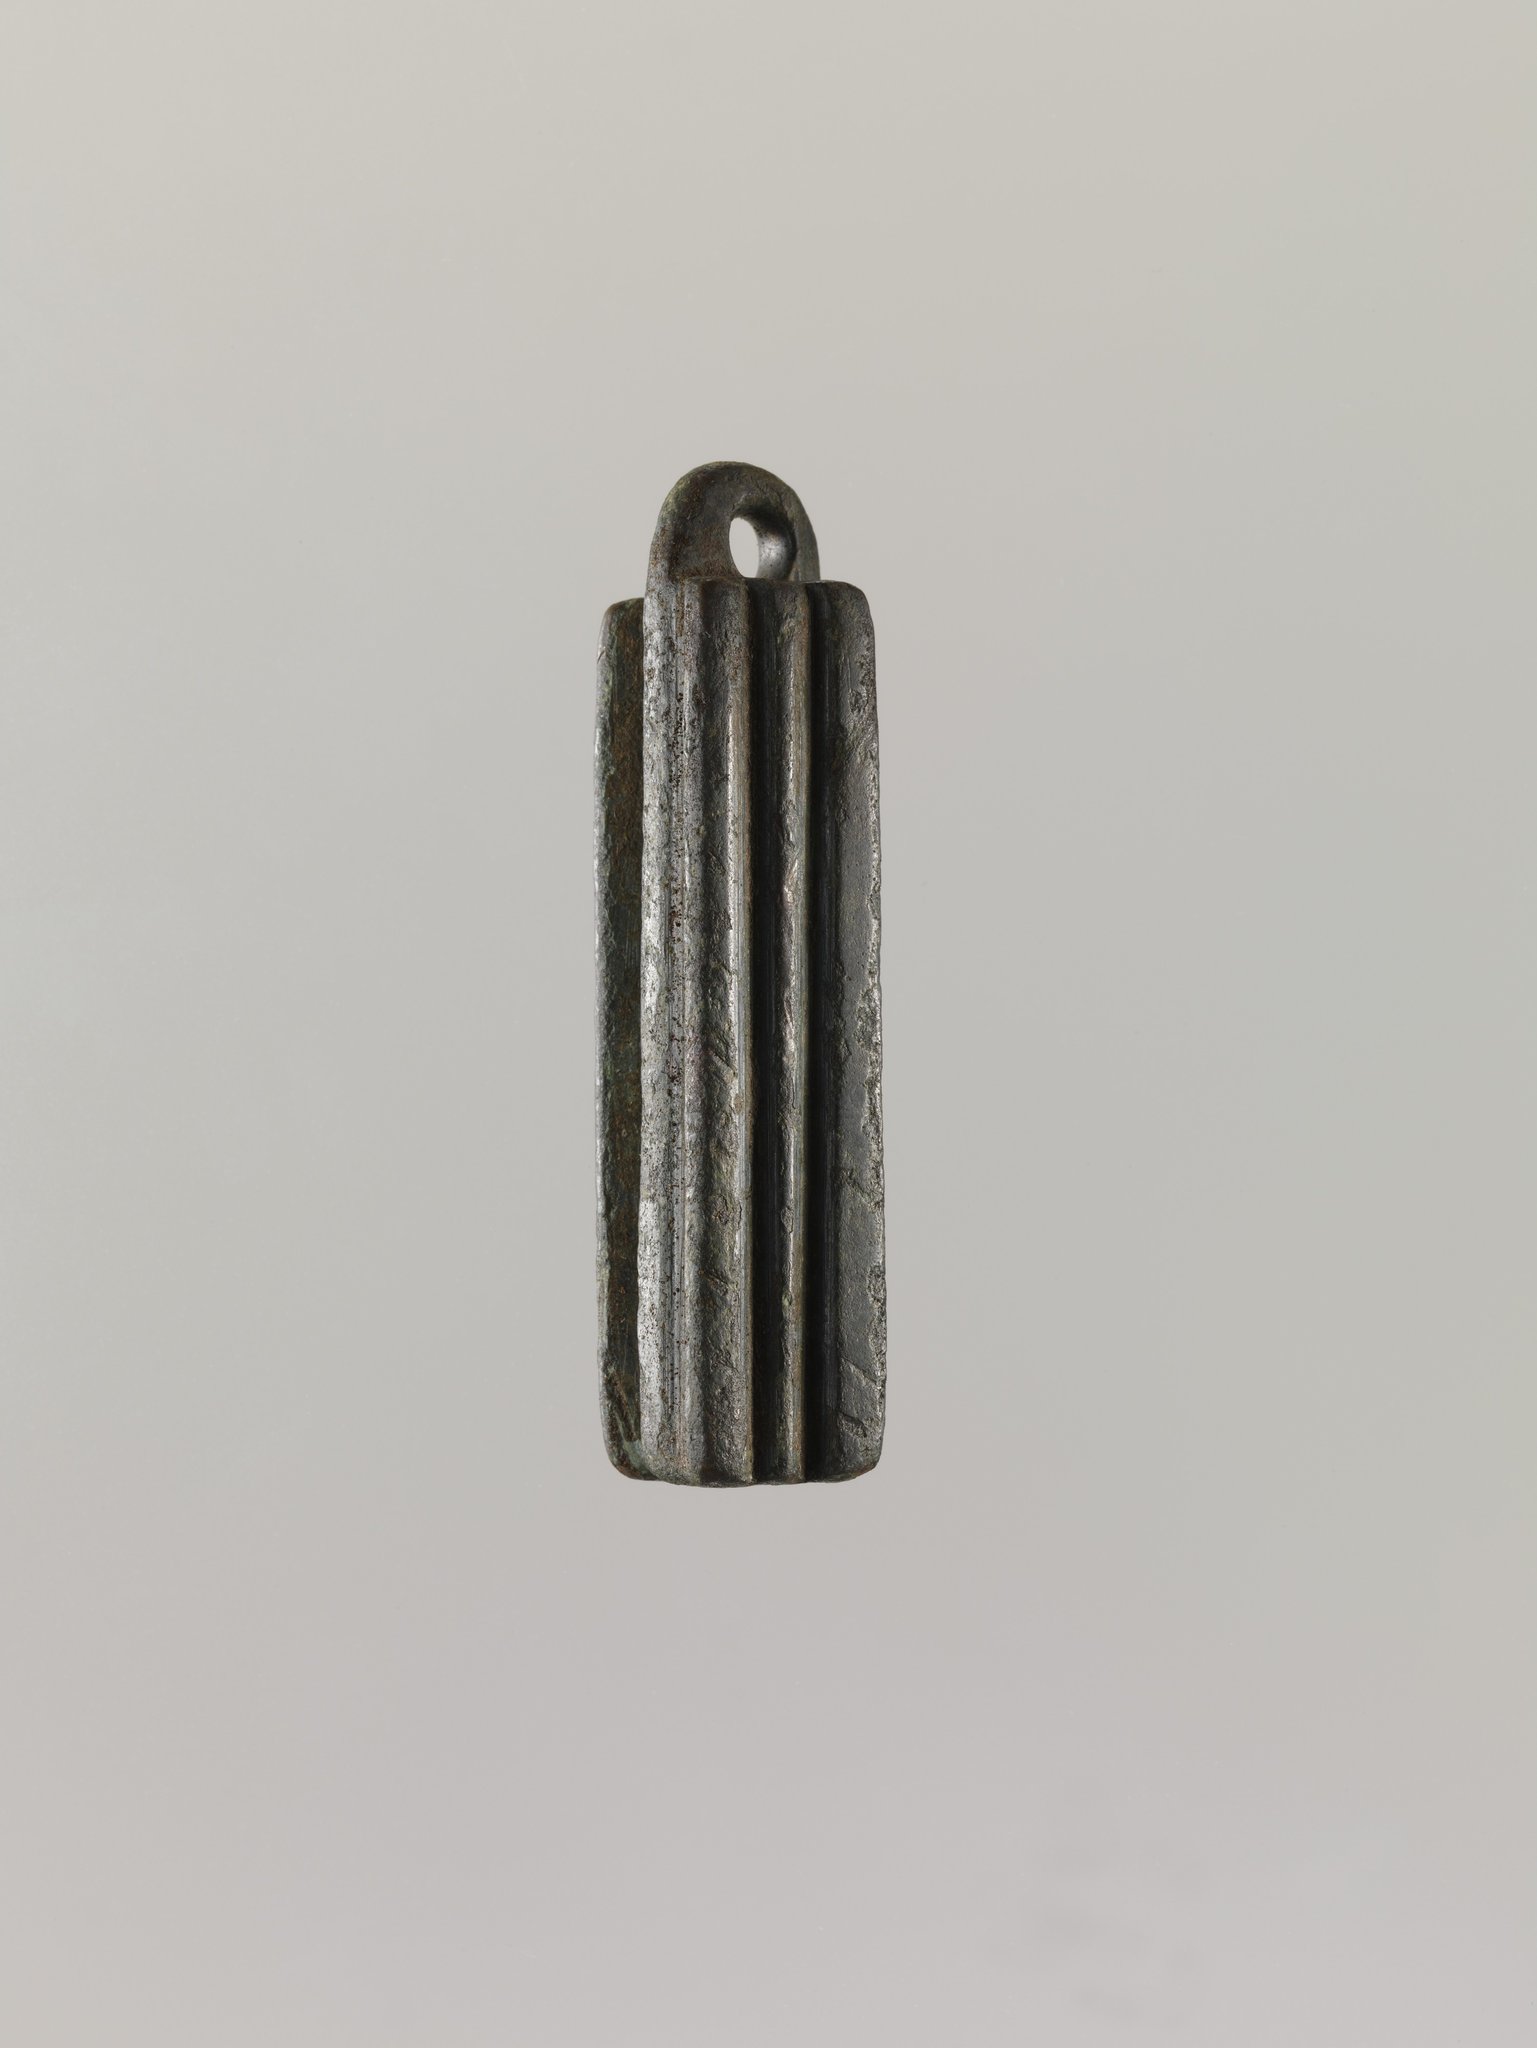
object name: coin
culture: chinese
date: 206 BCE-220 CE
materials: bronze